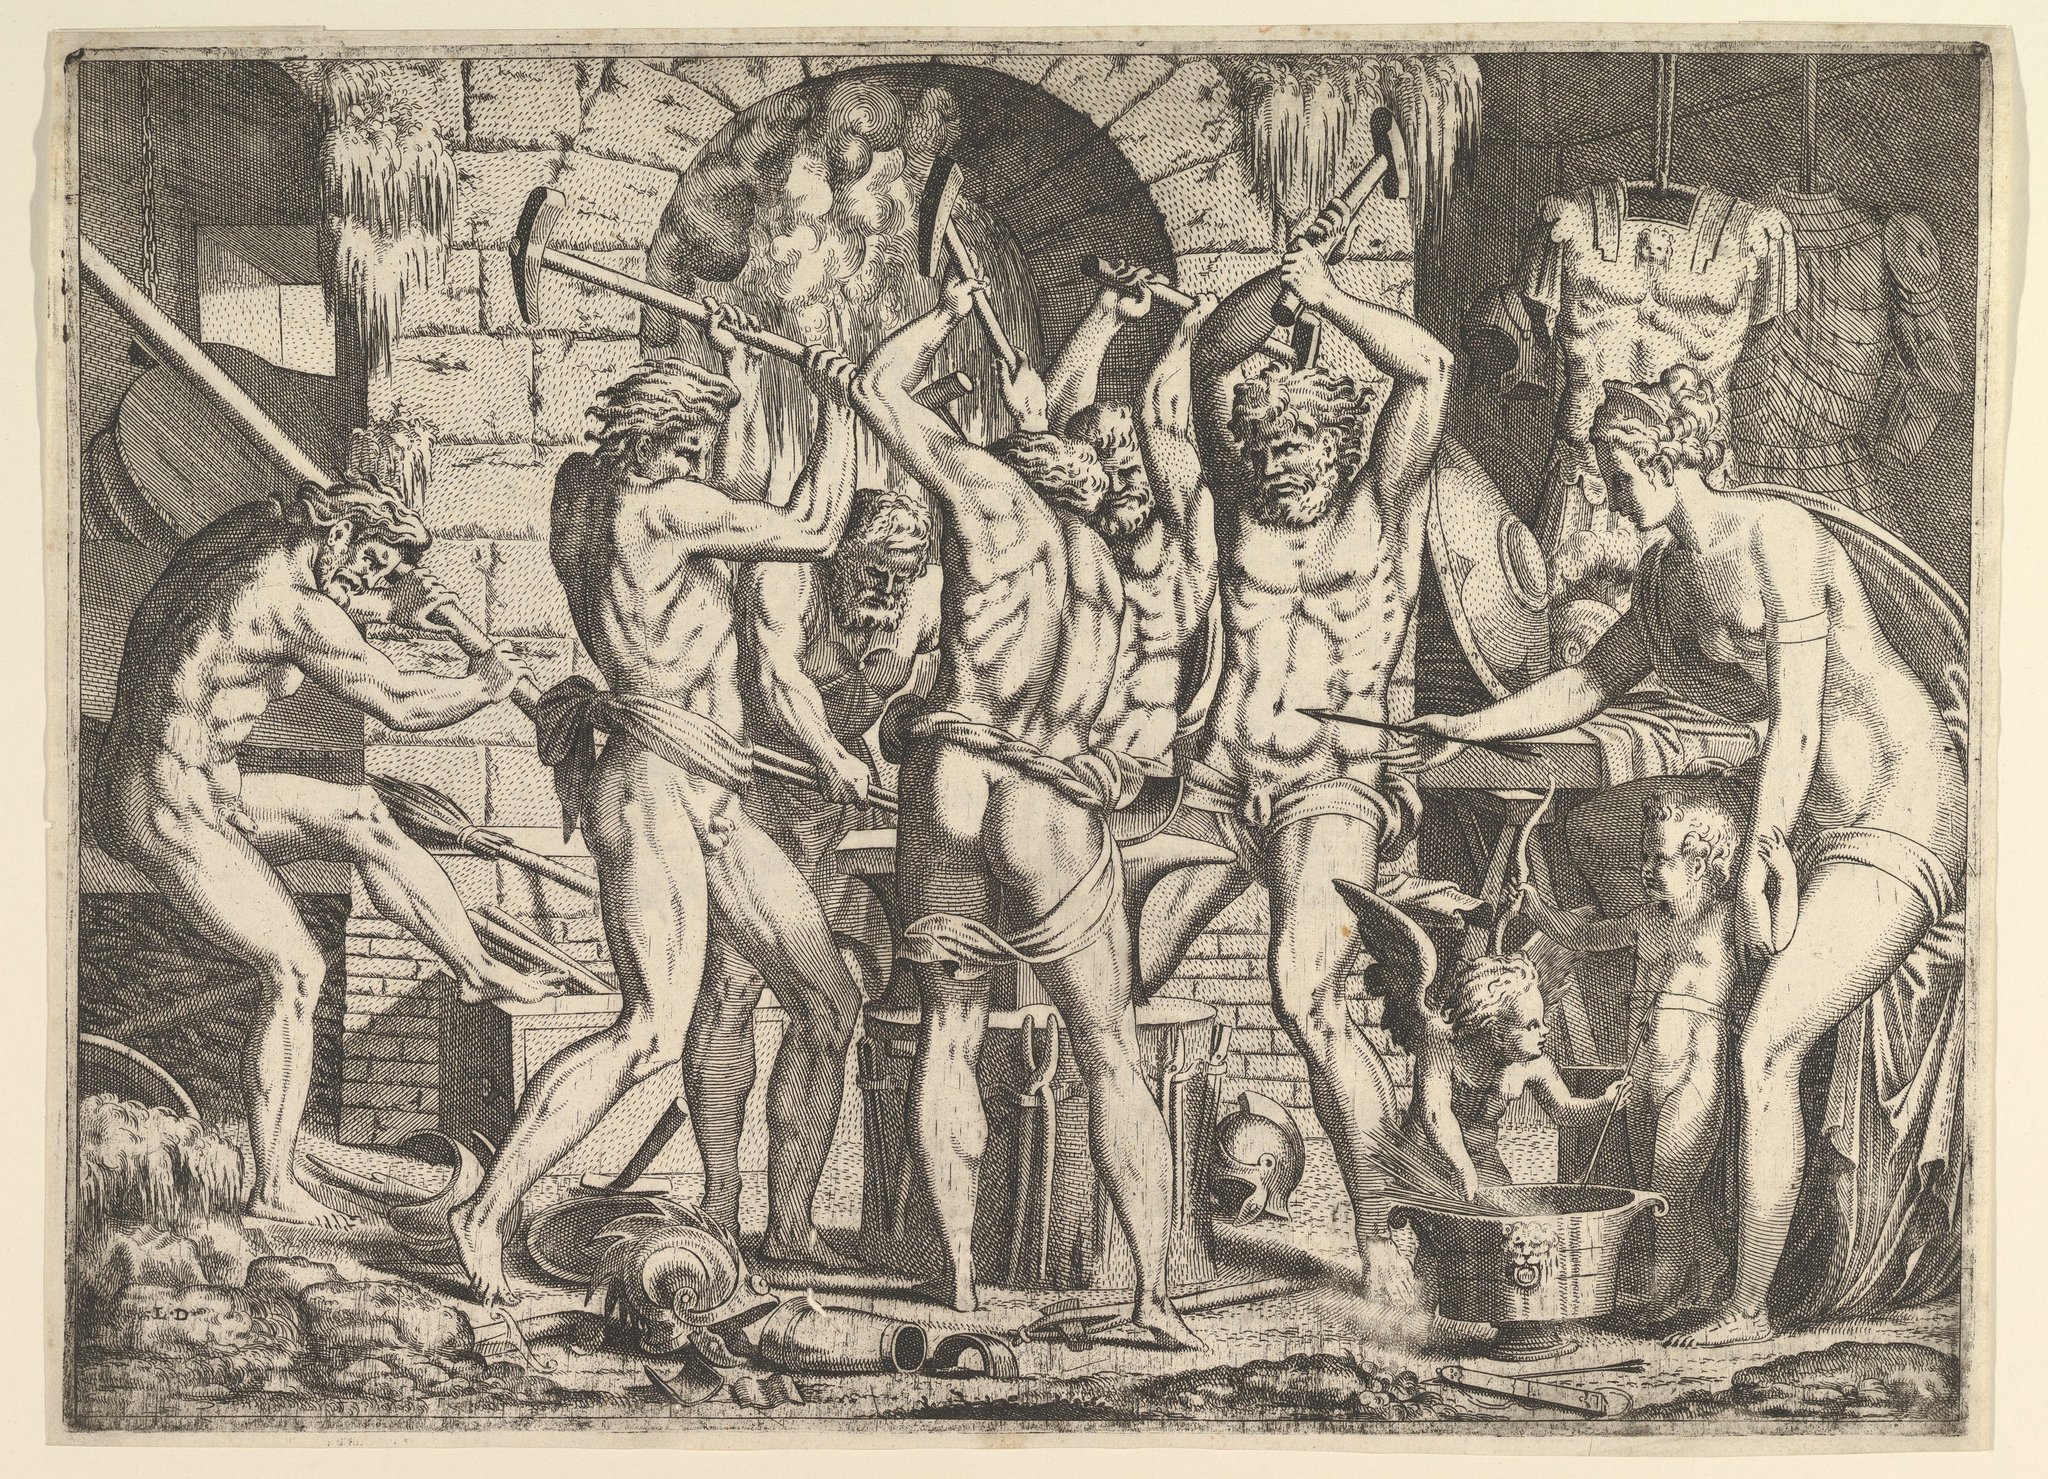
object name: print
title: Venus in Vulcan's Forge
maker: léon davent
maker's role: artist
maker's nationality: french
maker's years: 1540-1556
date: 1546-1547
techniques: etching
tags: venus,vulcan